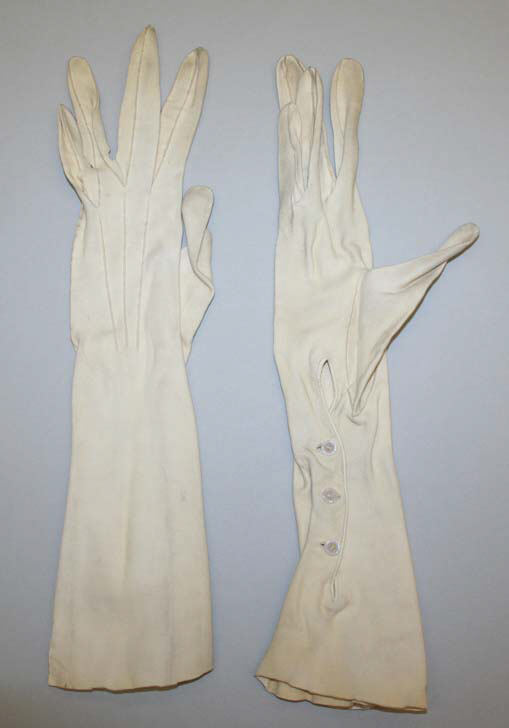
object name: glove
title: Gloves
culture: french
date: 1894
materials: leather